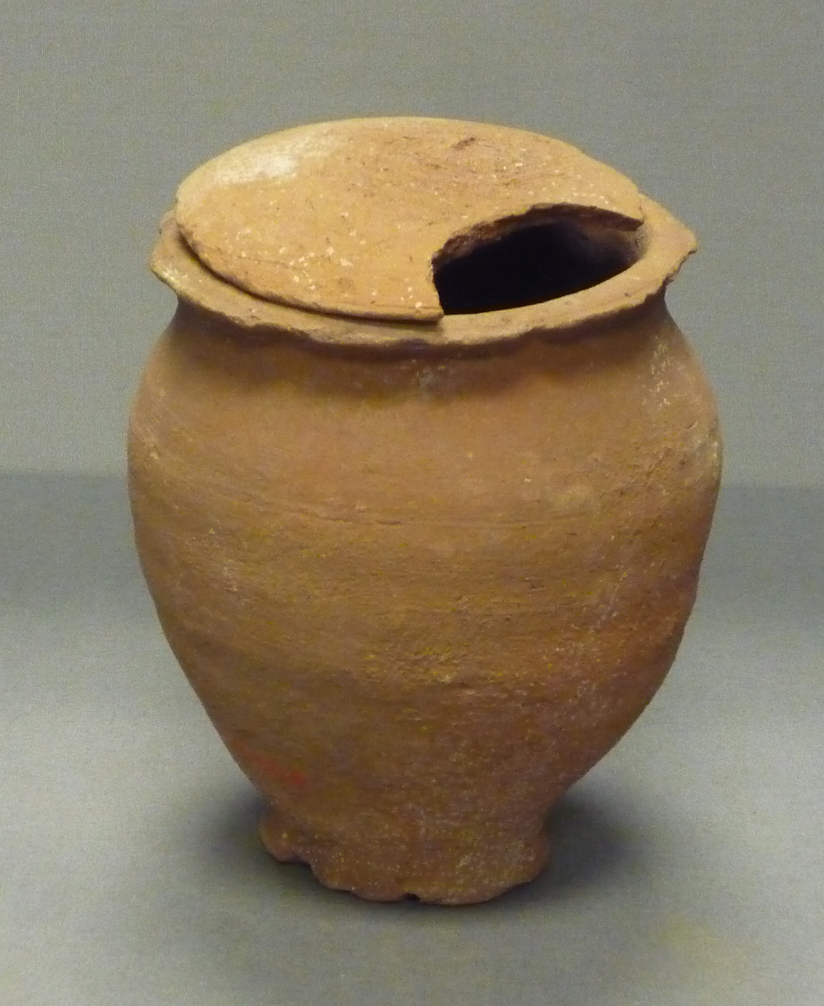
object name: jar with lid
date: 1479-1458 BCE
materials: pottery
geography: egypt